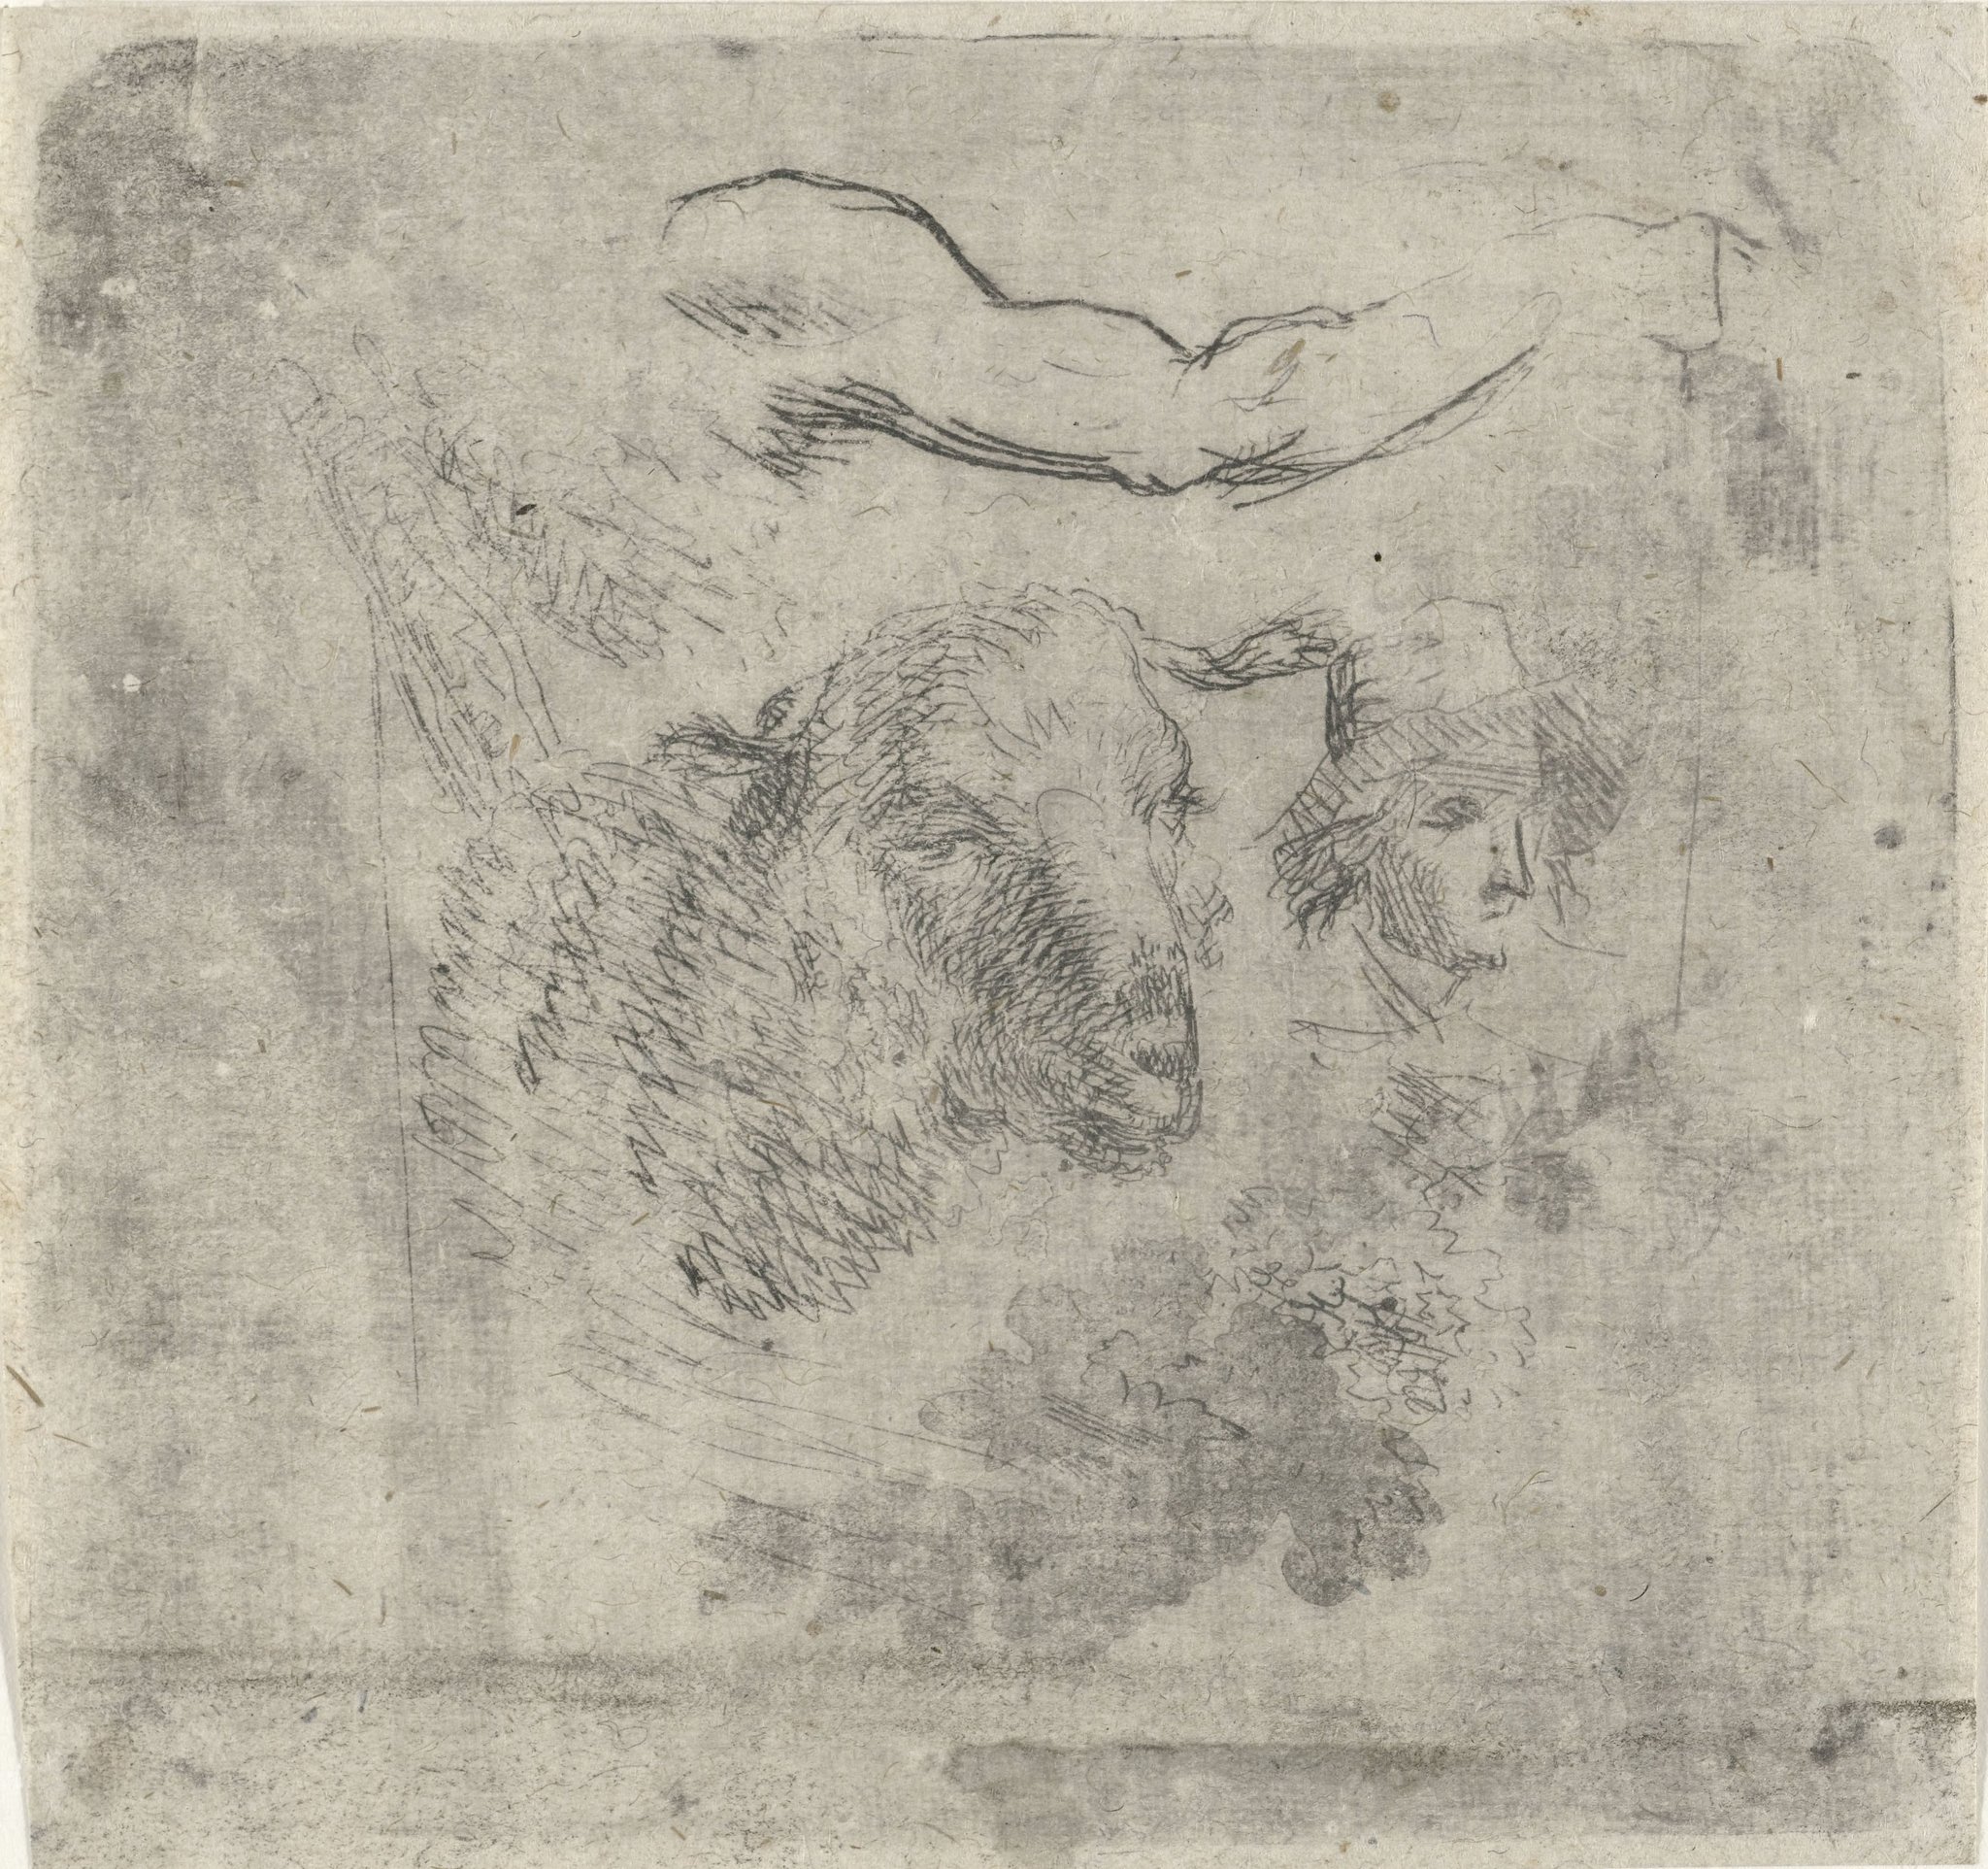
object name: print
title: Studieblad met schaap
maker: hermanus fock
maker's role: conservator, draughtsman, painter, print maker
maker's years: 1766-1822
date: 1781-1822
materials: paper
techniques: aquatint, etching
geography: amsterdam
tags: sheep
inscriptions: collector's mark: Lugt 2228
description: Studieblad met schetsen van de kop van een schaap, een manshoofd en een arm.